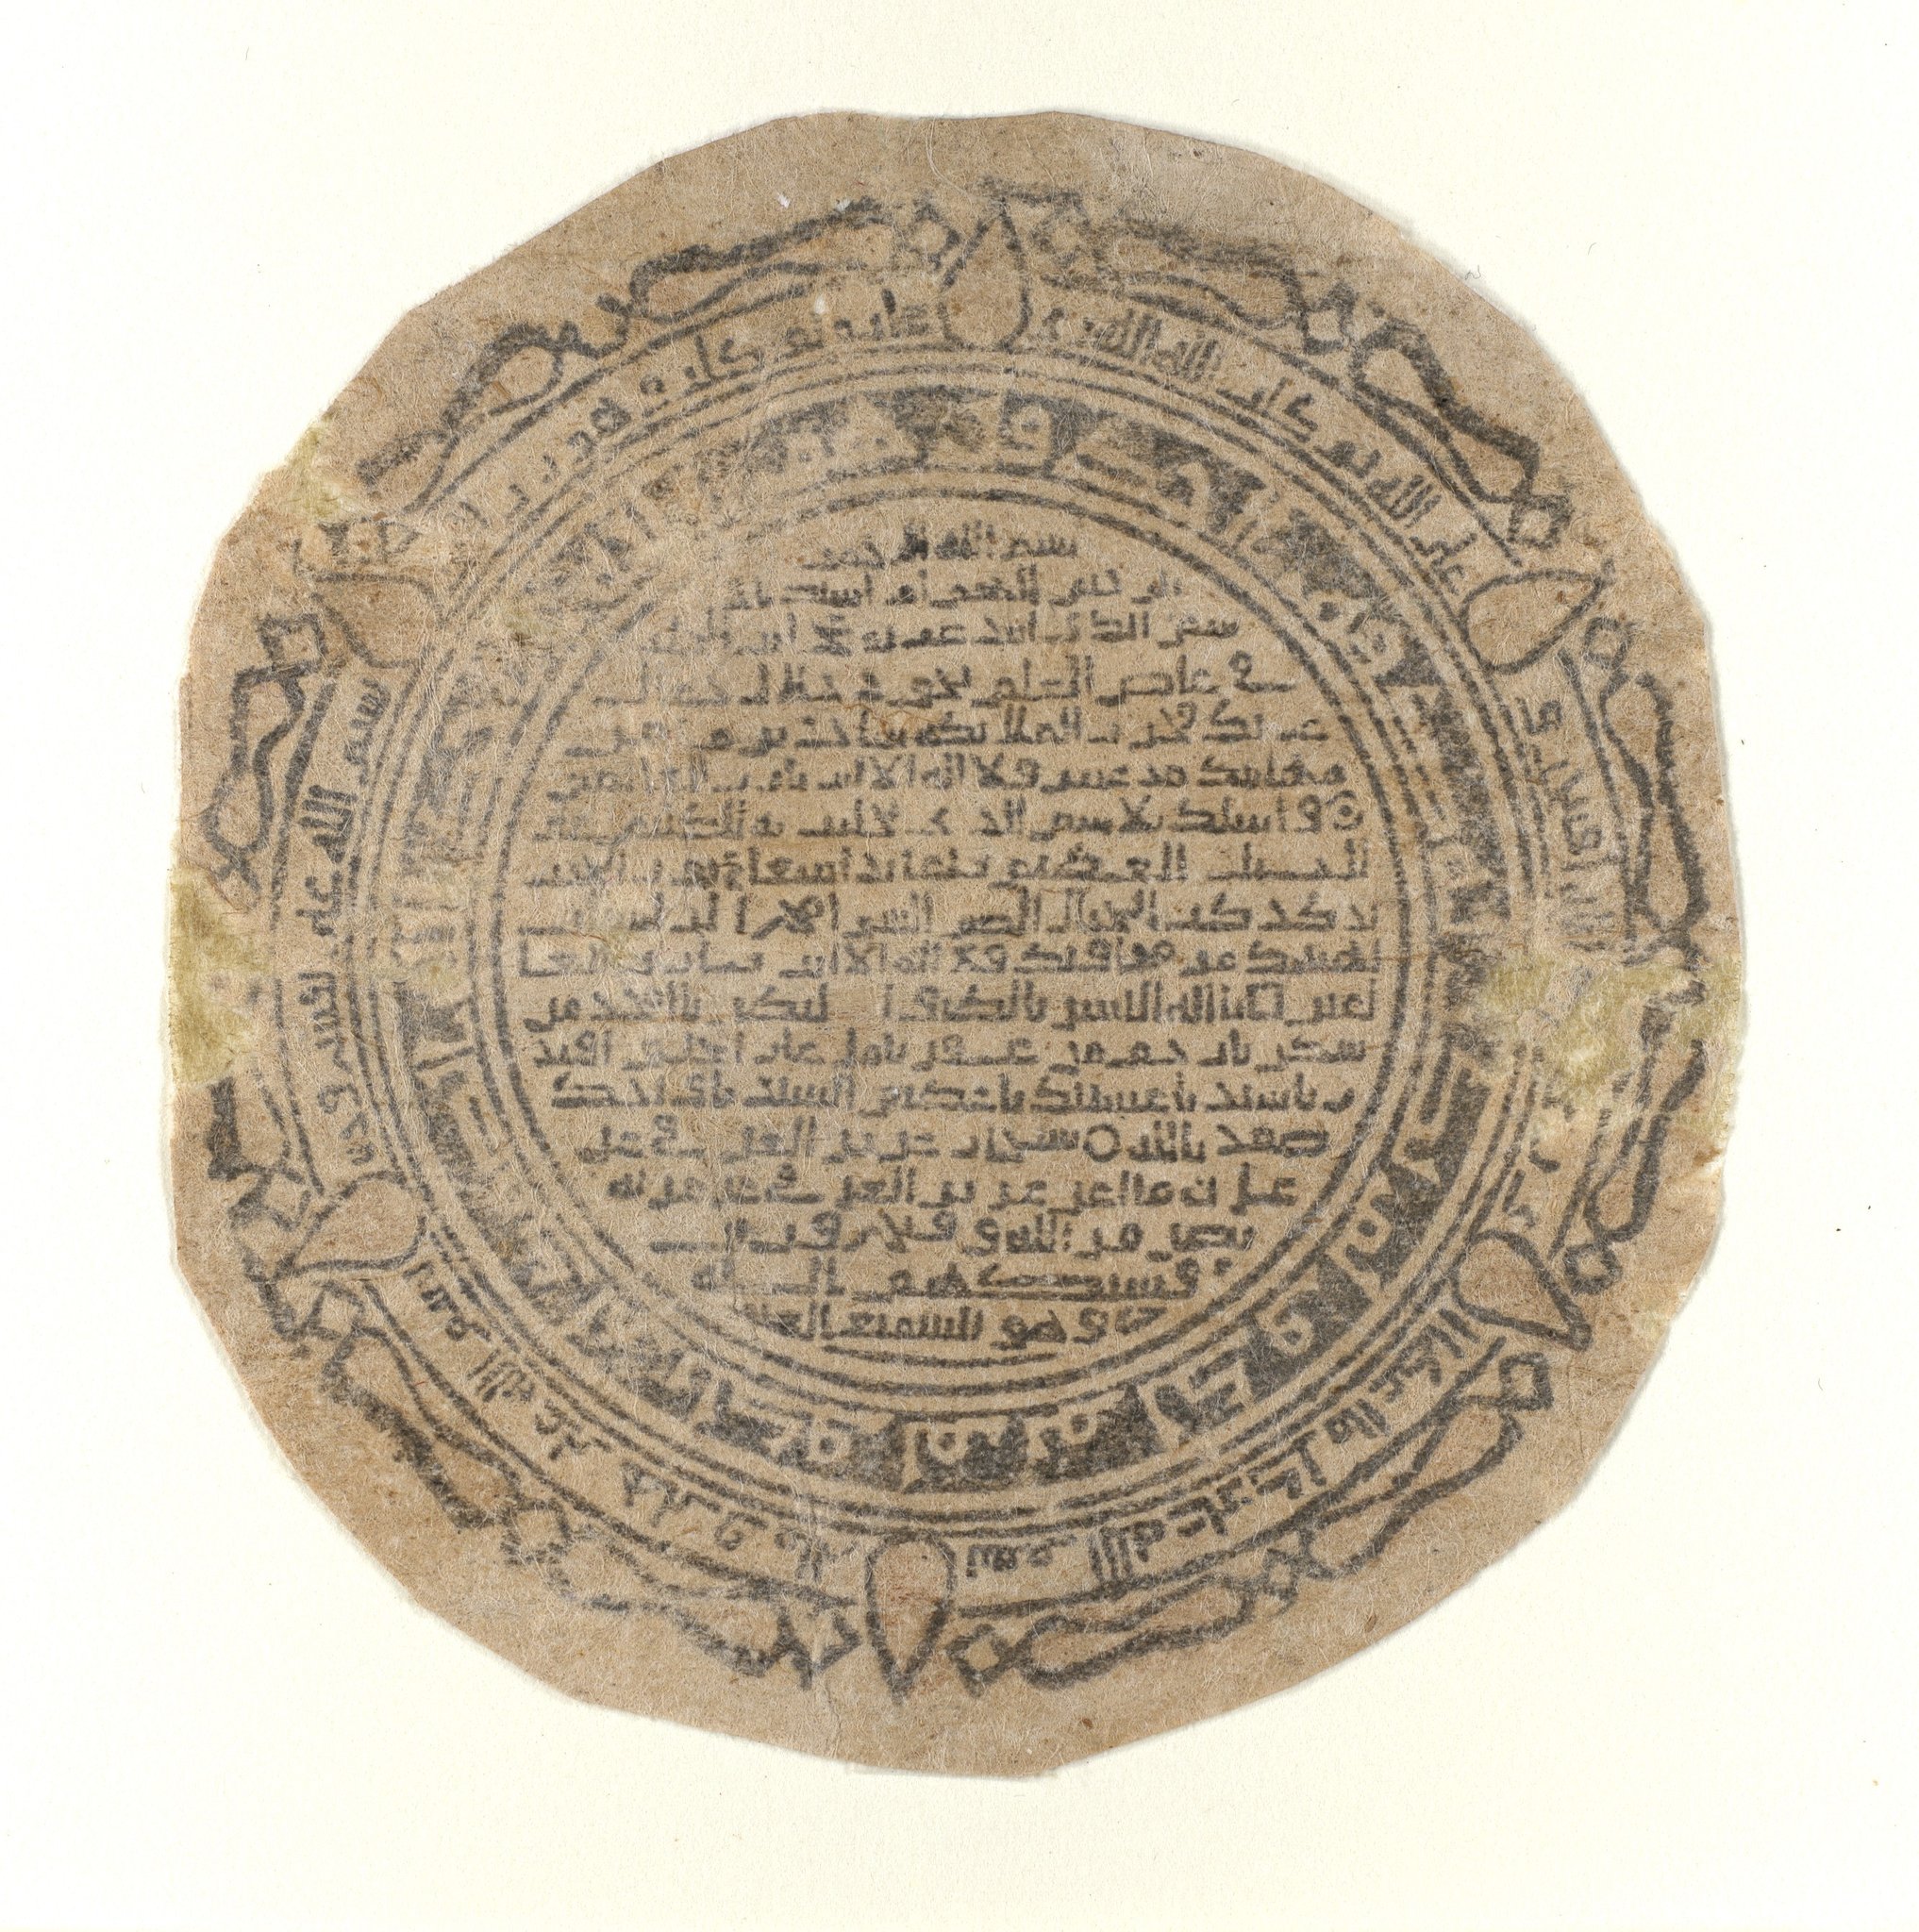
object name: folio from a non illustrated manuscript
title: Block-printed Talismanic Circular Leaf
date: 1001-1100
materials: ink, paper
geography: egypt